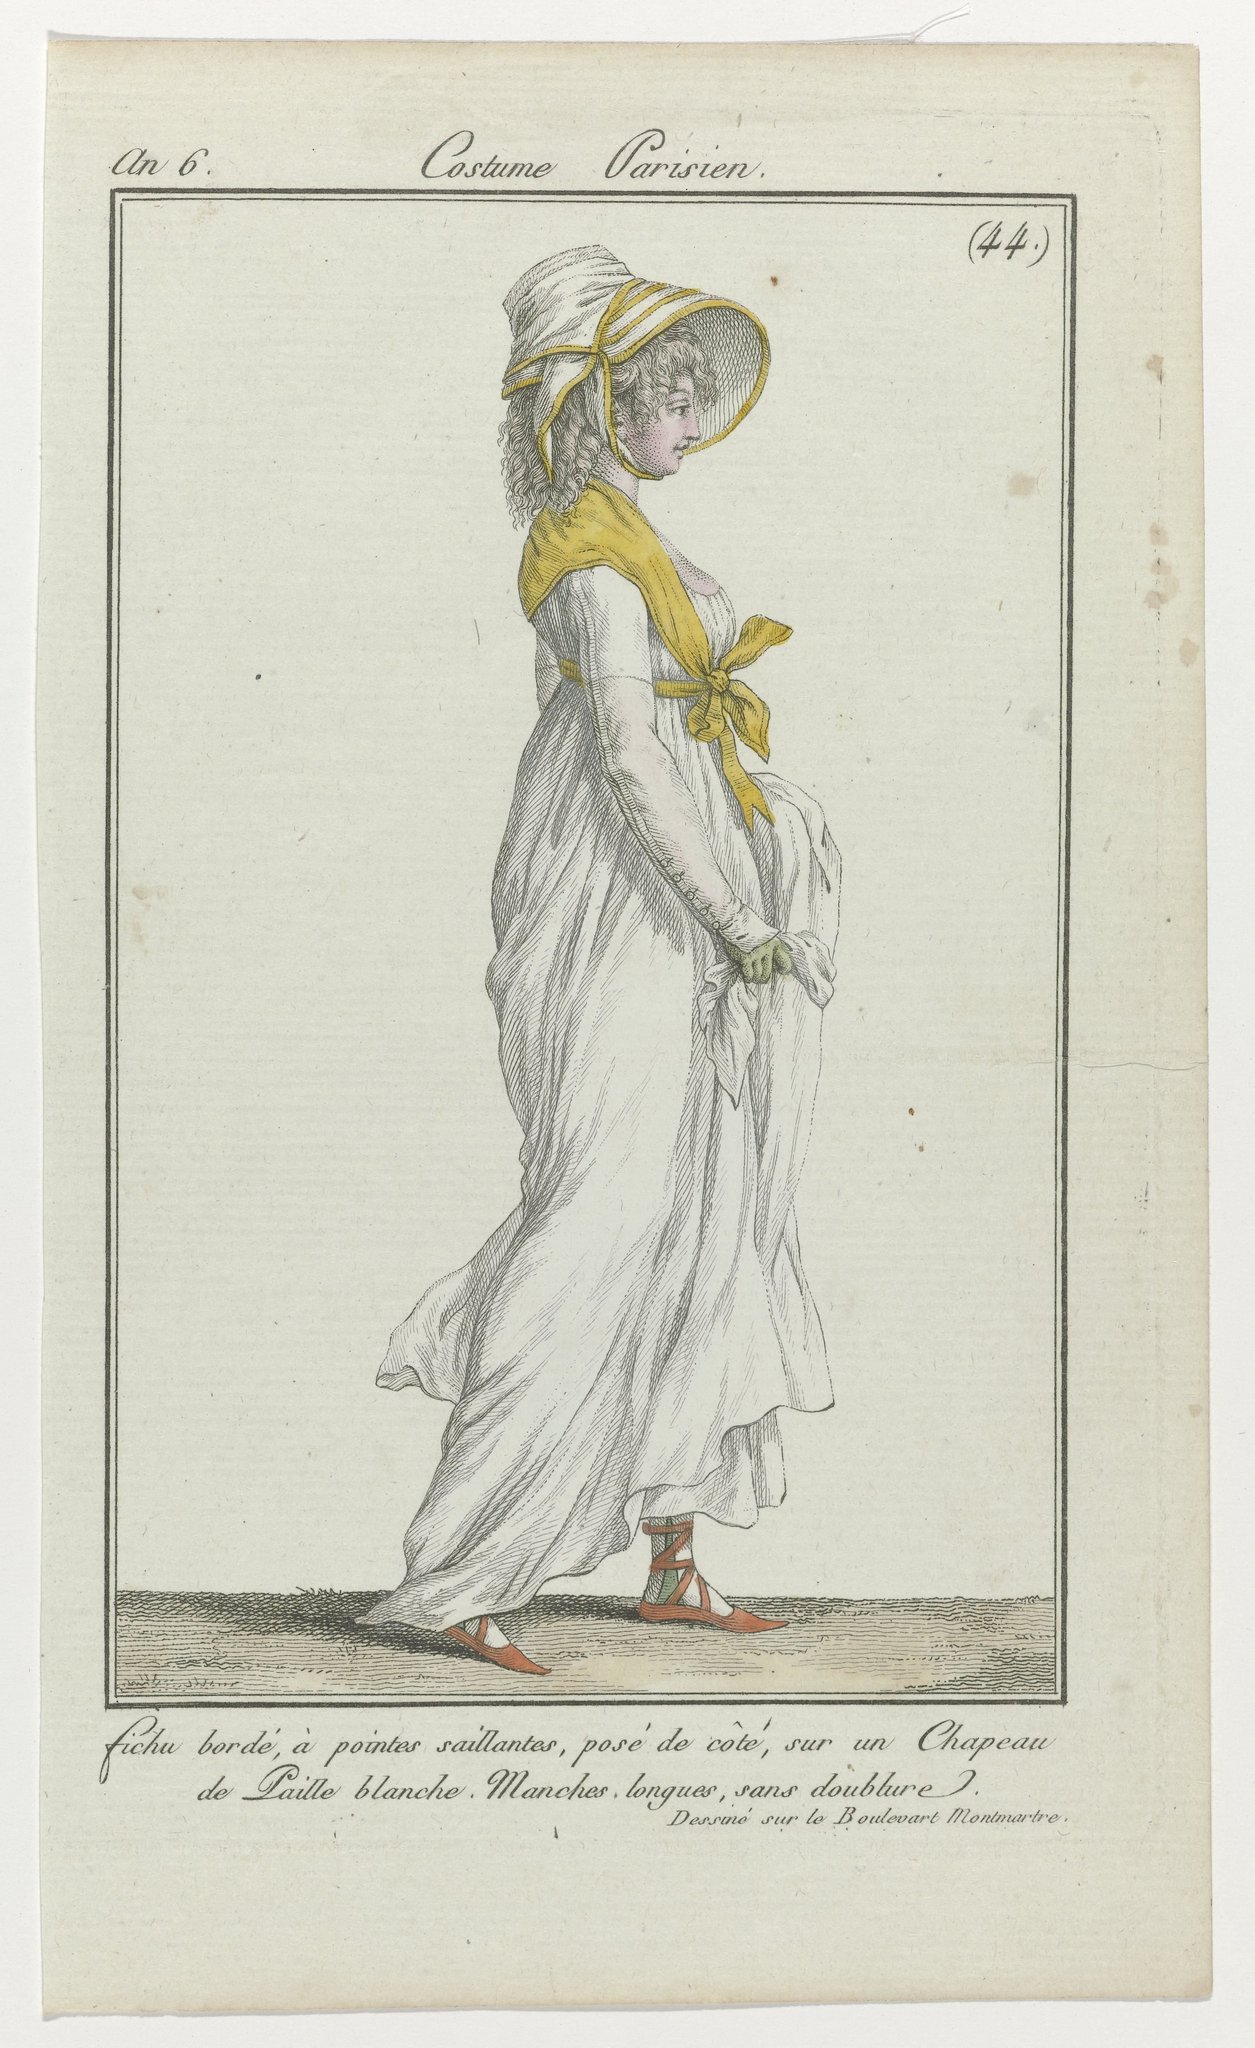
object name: fashion print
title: Journal des Dames et des Modes, Costume Parisien, 18 juin 1798, An 6, (44) : Fichu bordé, à pointes saillantes (...)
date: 1798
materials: paper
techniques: engraving, hand coloring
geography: paris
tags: handkerchief (+ women's clothes), head-gear (+ women's clothes), fashion plates, gloves, mittens, etc. (+ women's clothes), dress, gown (+ women's clothes), shoes, sandals, piece of clothing covering the breast or décolleté (fichu) (+ women's clothes), sleeves (+ women's clothes)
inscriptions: title: ‘Costume Parisien.’, caption: ‘Fichu bordé, à pointes saillantes, posé de côté, sur un Chapeau de Paille blanche. Manches longues, sans doublure.’, caption: ‘Dessiné sur le Boulevart Montmartre.’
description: Witte strohoed waarover schuin een fichu is geplaatst, omzoomd en met uitstekende punten. Japon met lange ongevoerde mouwen en een fichu, die onder de buste is gestrikt. Verdere accessoires: zakdoek, handschoen, kousen, schoenen met linten en puntige neuzen ('cothurnes'). Volgens het onderschrift is deze voorstelling naar het leven getekend op de 'Boulevart(!) Montmartre'. De prent maakt deel uit van het modetijdschrift Journal des Dames et des Modes, uitgegeven door Sellèque, Parijs, 1797-1839.